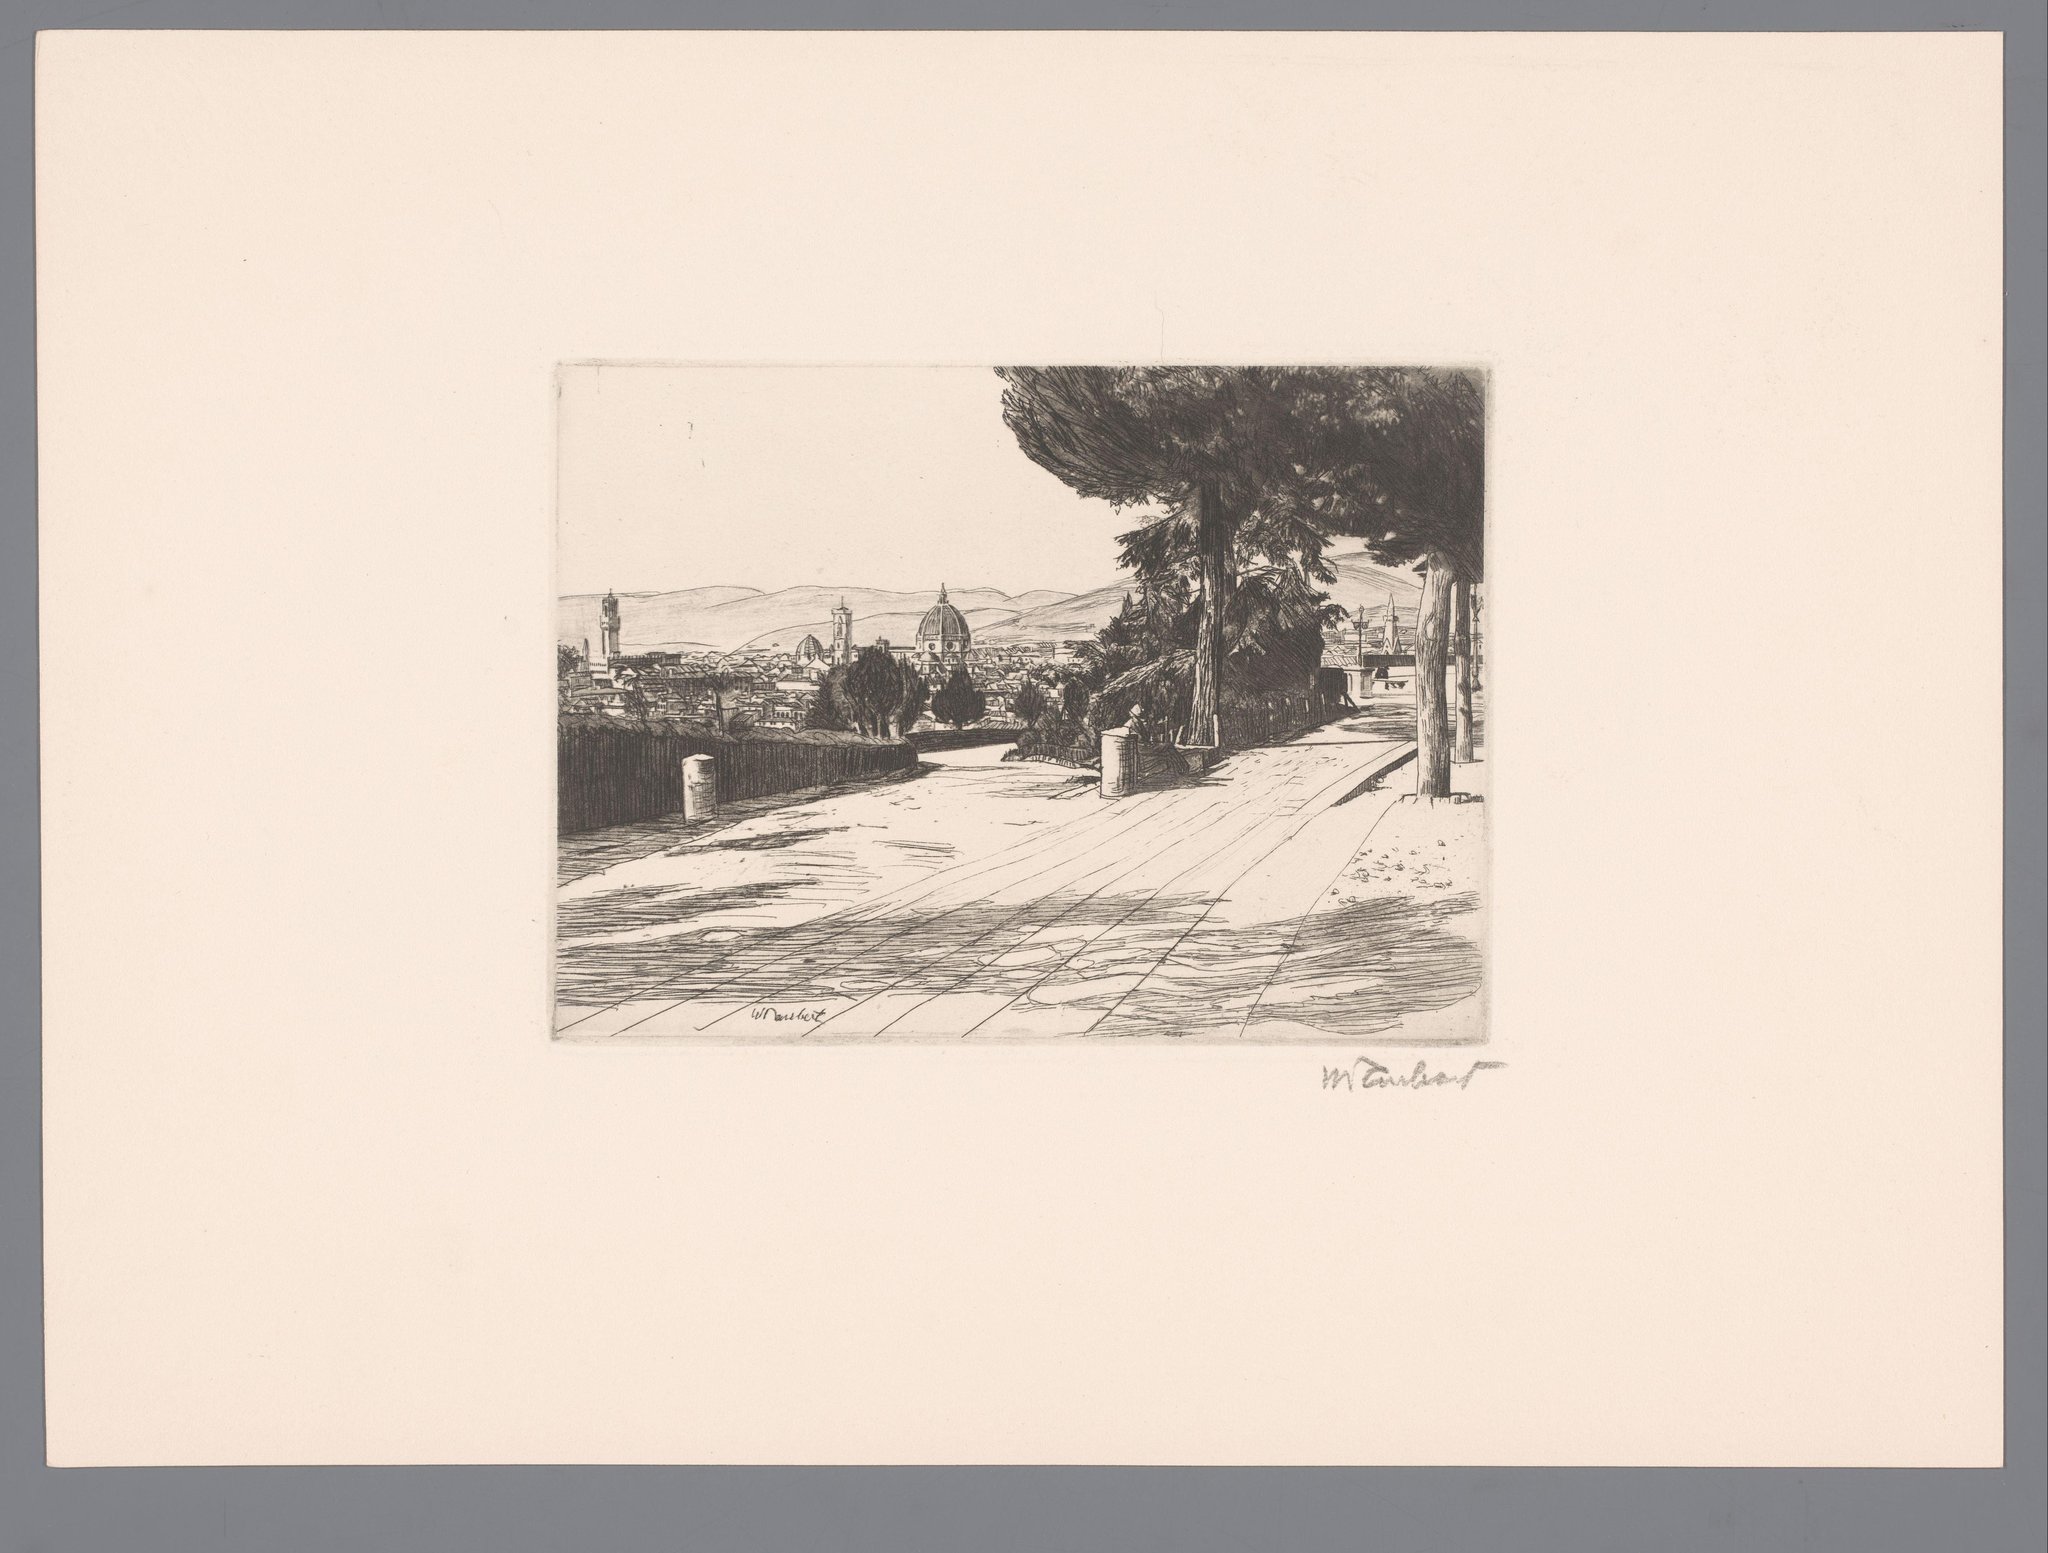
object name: print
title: Gezicht op Florence met in de verte Palazzo Vecchio en de Dom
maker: guglielmo taubert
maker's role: print maker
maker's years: 1876-1949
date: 1886-1927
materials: paper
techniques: aquatint, etching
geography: florence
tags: city-view in general; 'veduta', church (exterior)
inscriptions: inscription: ‘M Taubert’, collector's mark: Lugt 2228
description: Prent maakt deel uit van een serie van tien prenten met gezichten op Florence. De prenten worden bij elkaar bewaard in een omslag met daarop de serietitel en een portret van de prentmaker.